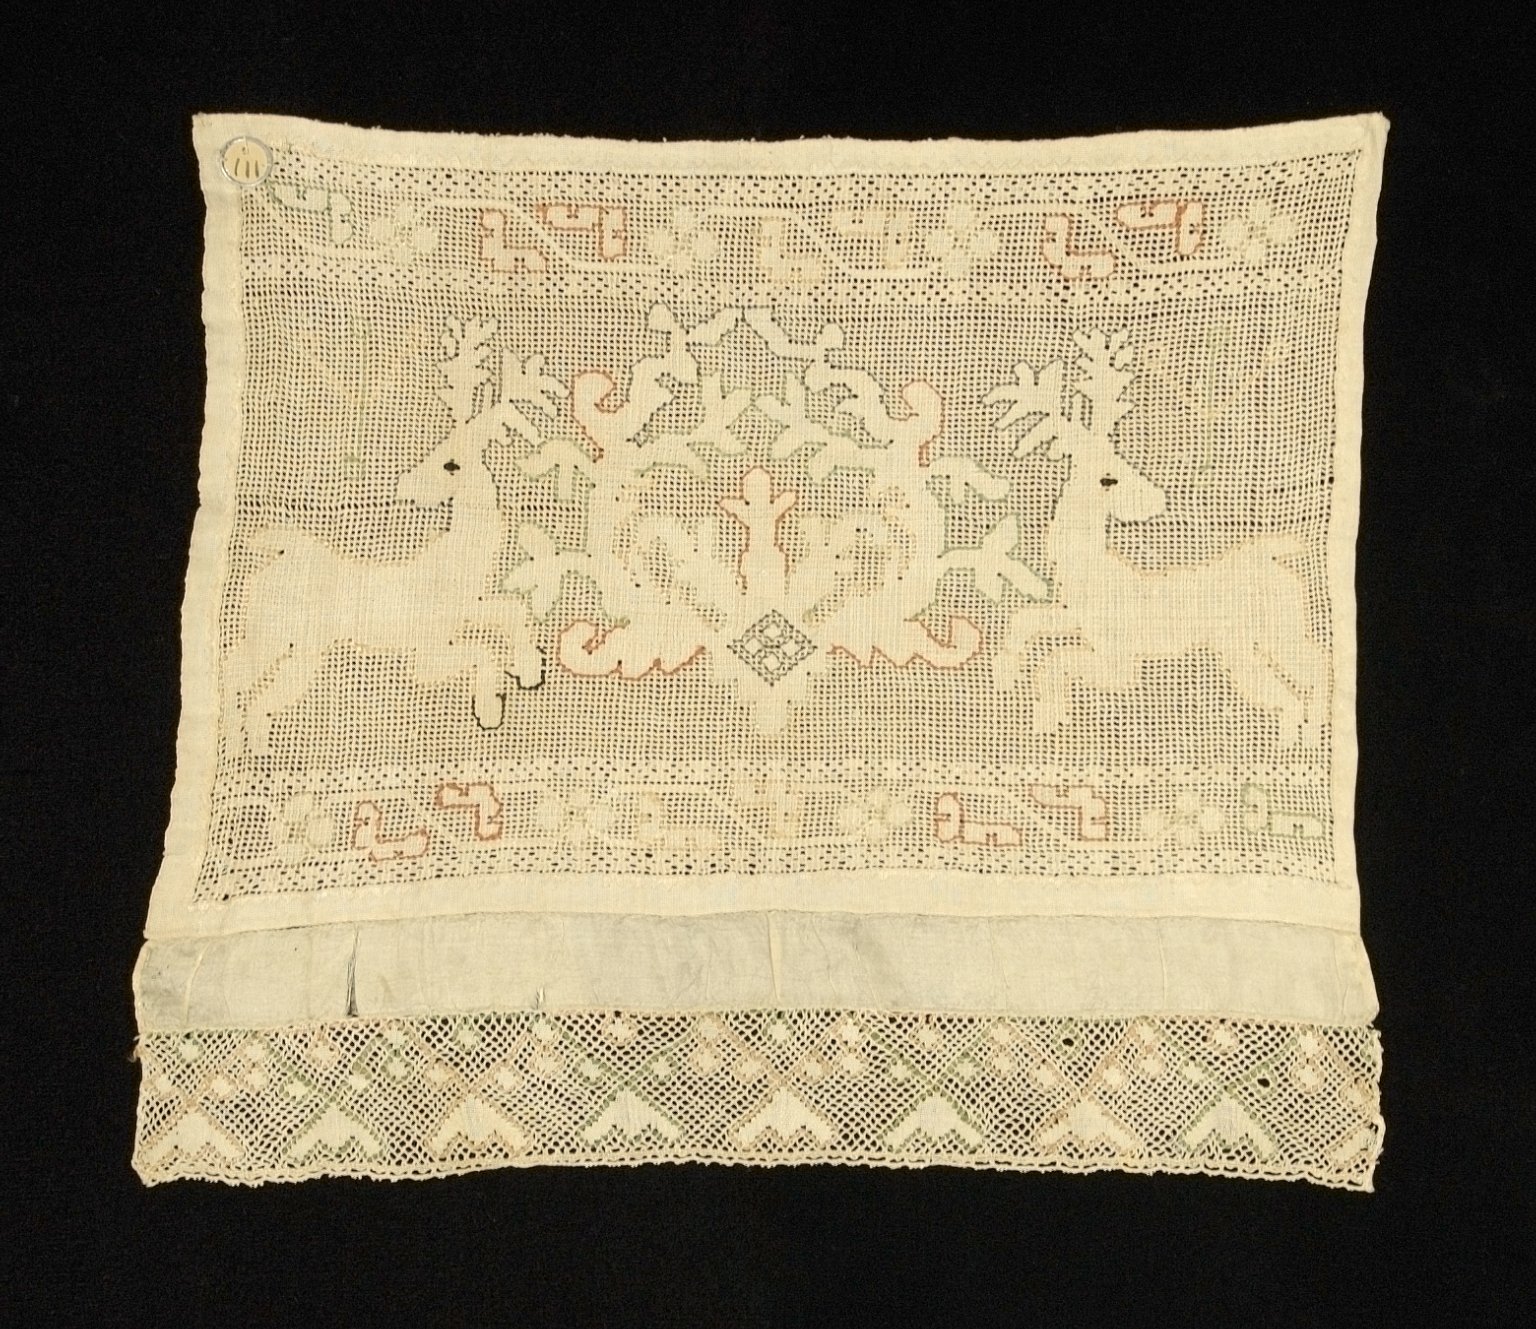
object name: border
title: Towel border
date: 1780-1820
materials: linen, silk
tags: deer